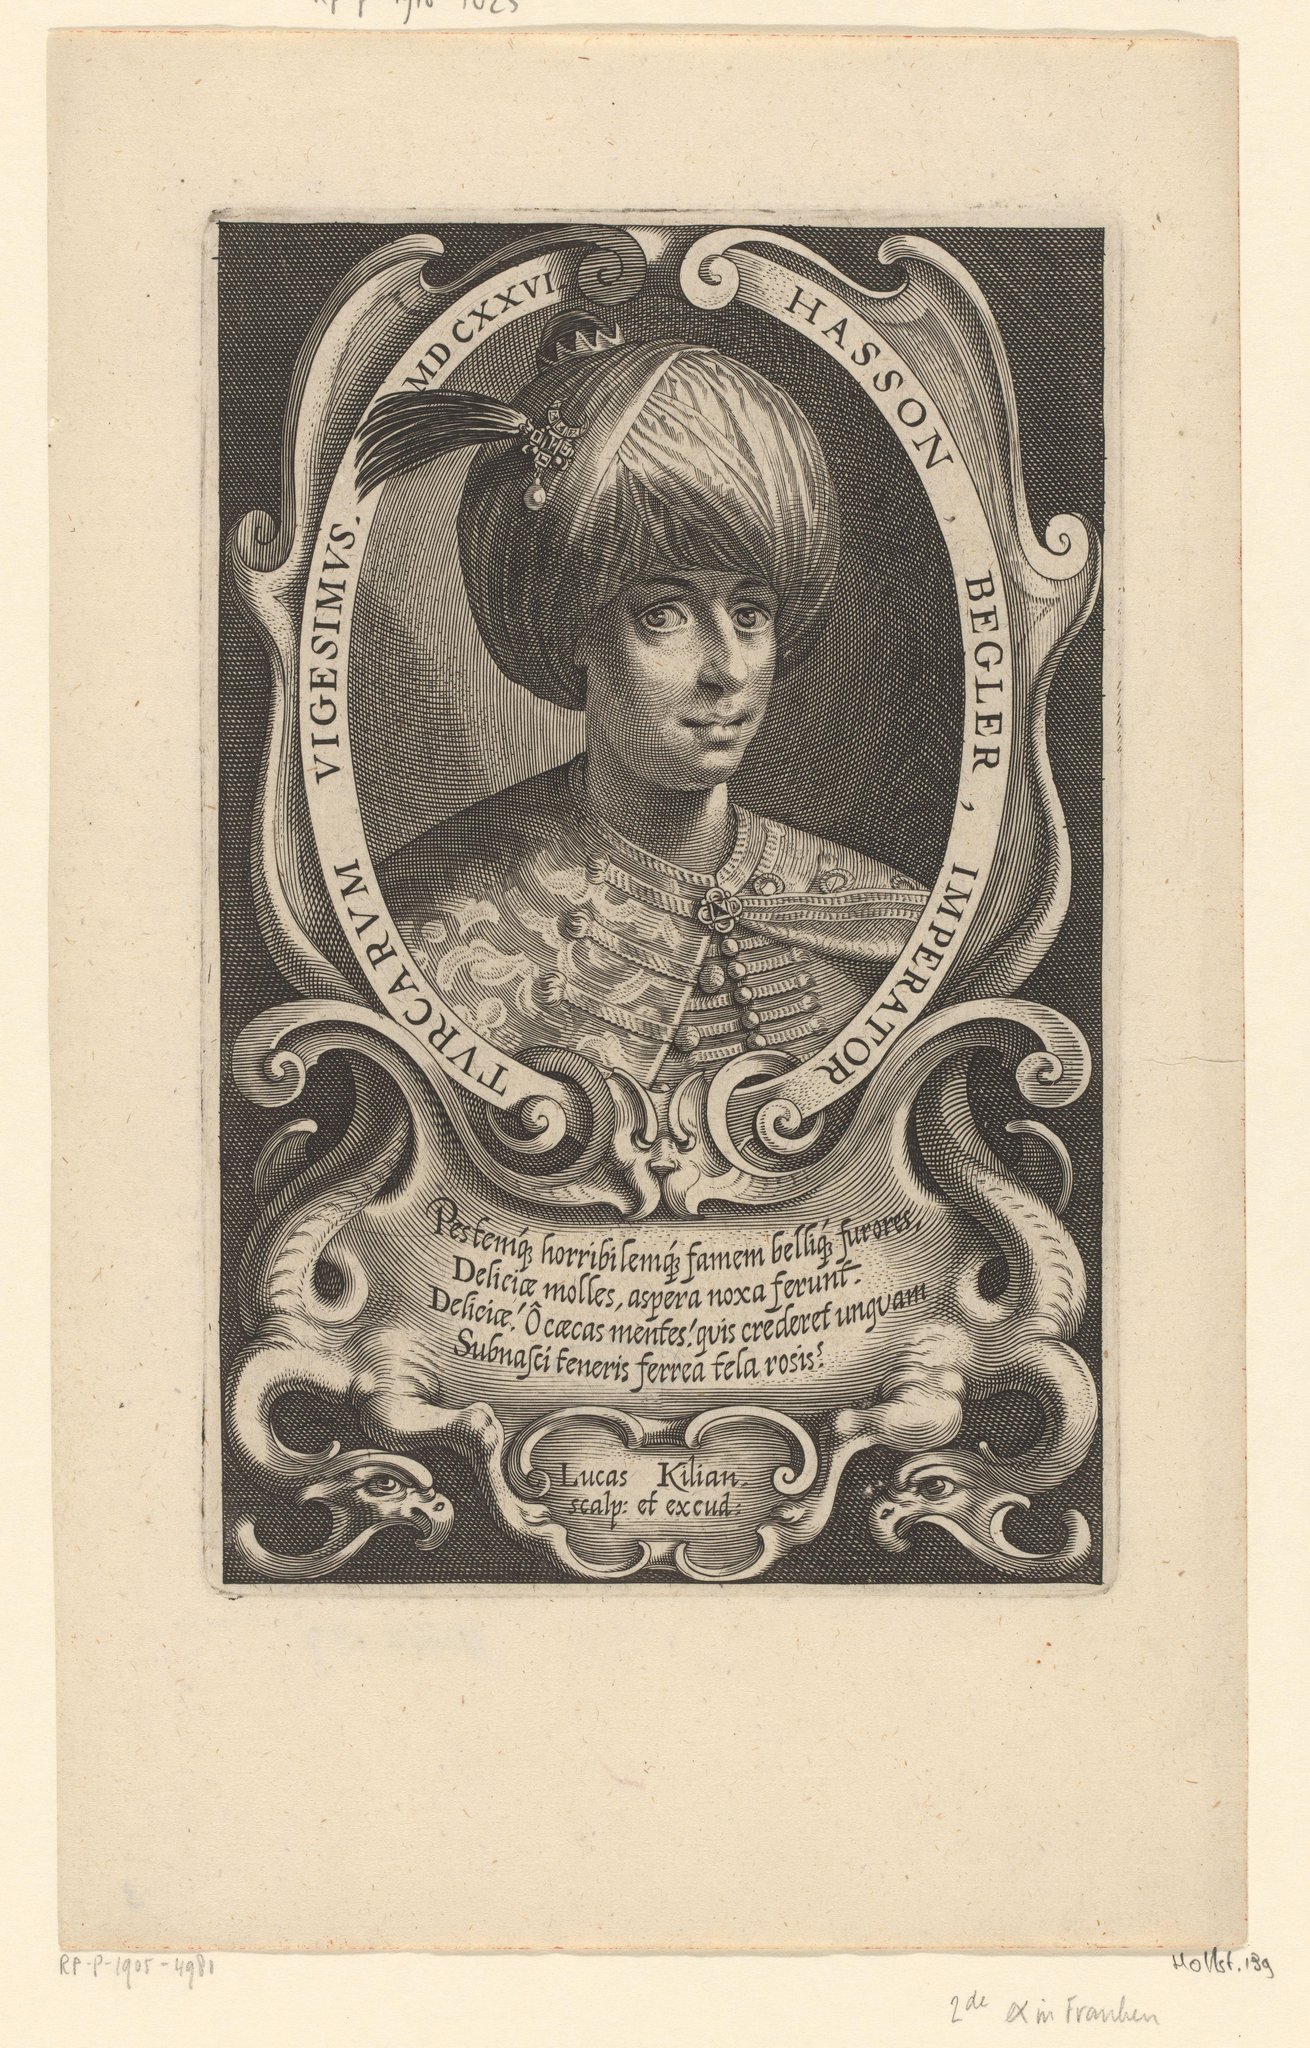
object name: print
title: Portret van Hassan Khodja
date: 1626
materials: paper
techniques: engraving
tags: historical persons, ruler, sovereign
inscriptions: collector's mark: Lugt 2228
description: Begler is een verbastering van 'Beylerbey', 'Beglerbeg(i)' of 'بكلربكی' : een titel voor een belangrijke gouverneur of generaal in het West-Ottomaanse Rijk. Dit is mogelijk een afbeelding van de in 1626 als Beglerbegi aangestelde Hasson Khodja of van de veertienjarige Sultan Murat VI als vertegenwoordiger, gezien de toon van de tekst in de cartouche.